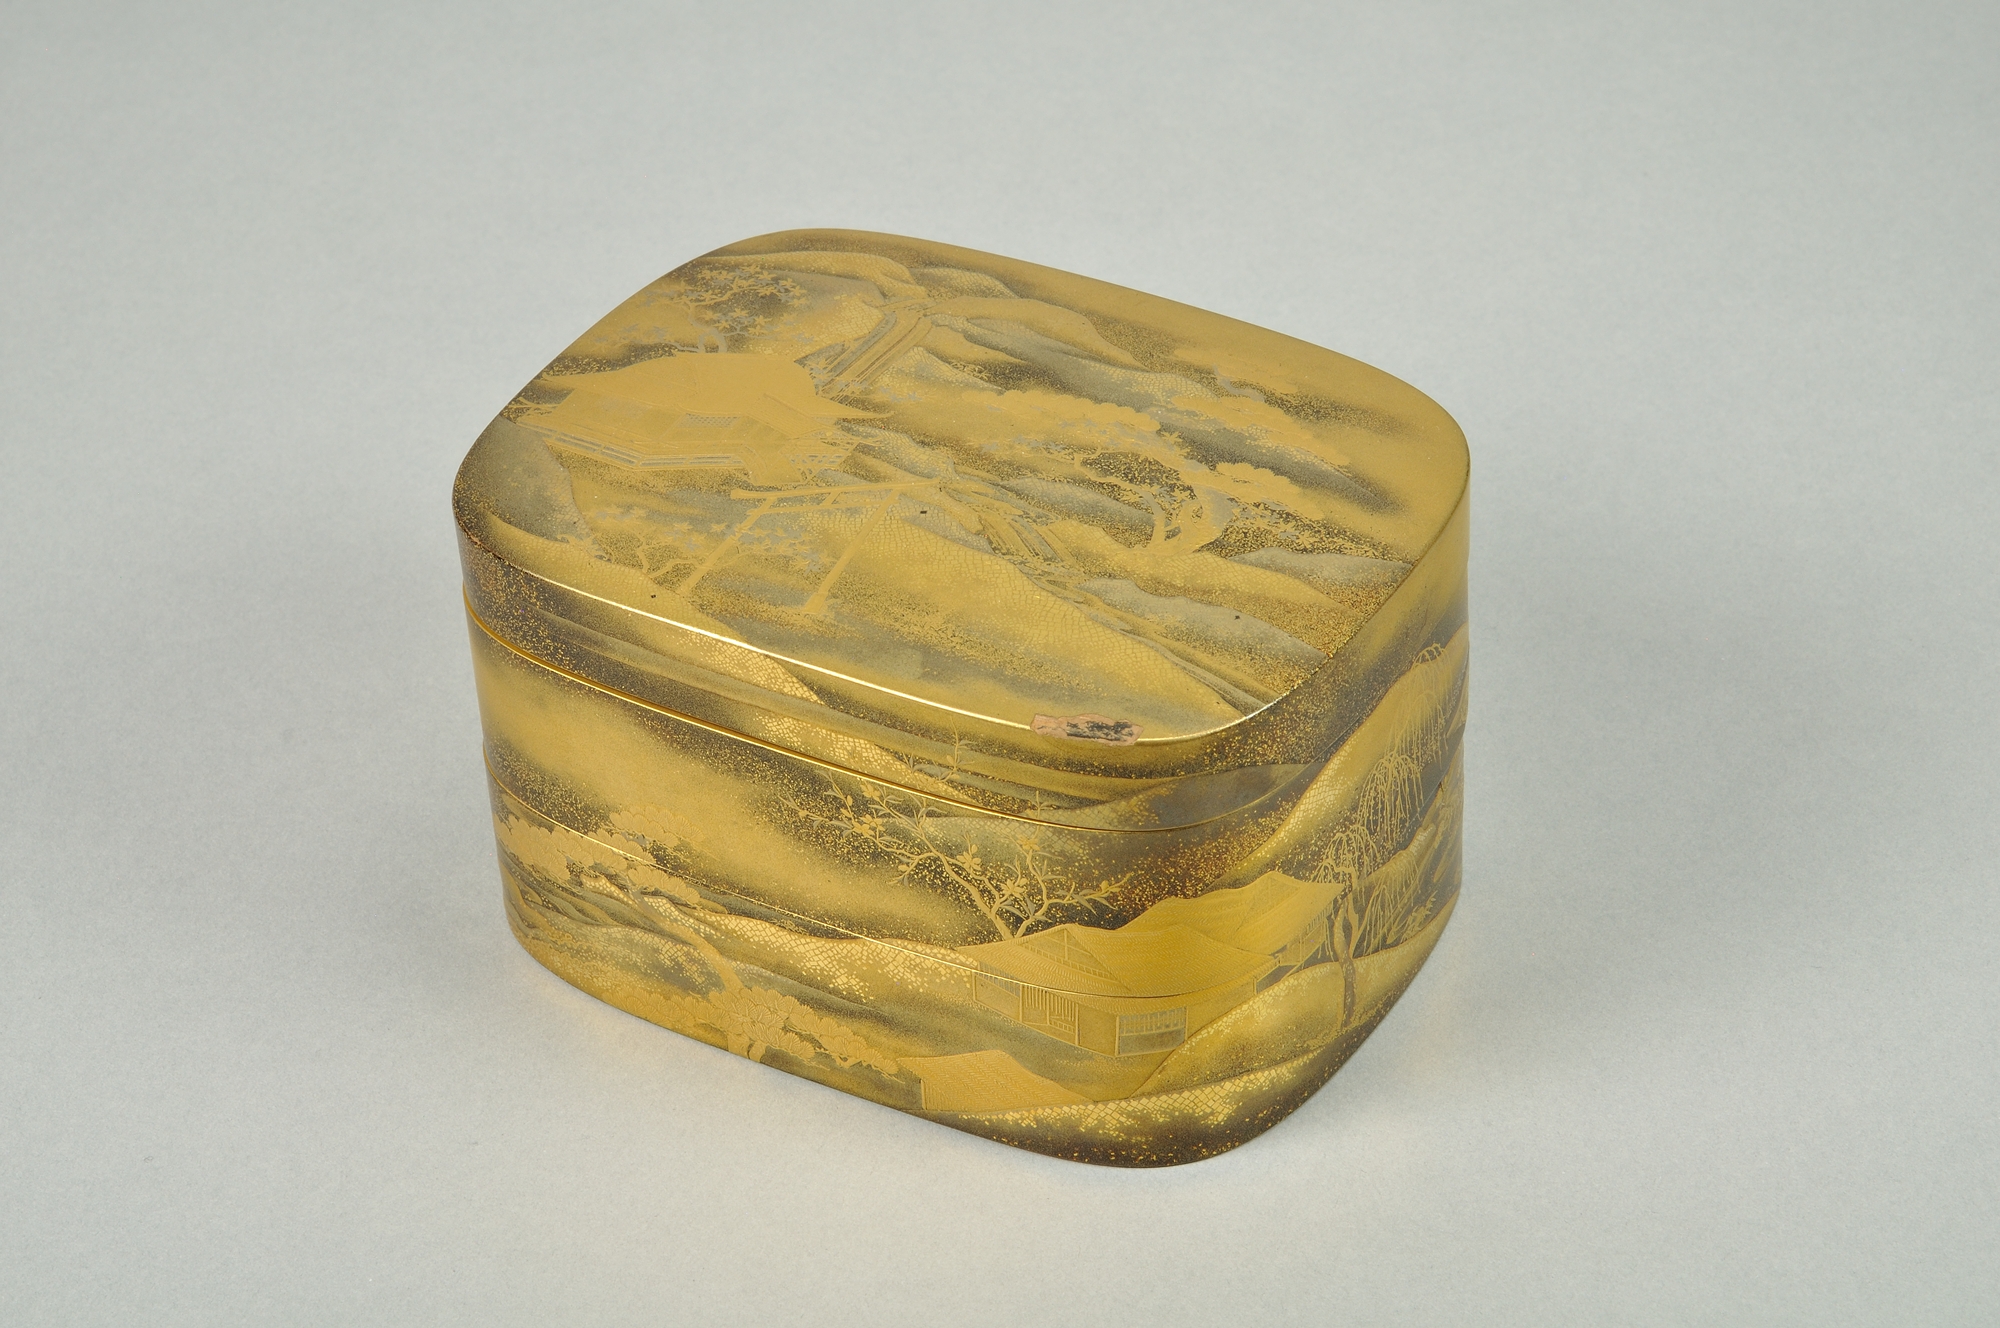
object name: incense box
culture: japanese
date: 1867-1900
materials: lacquer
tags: trees